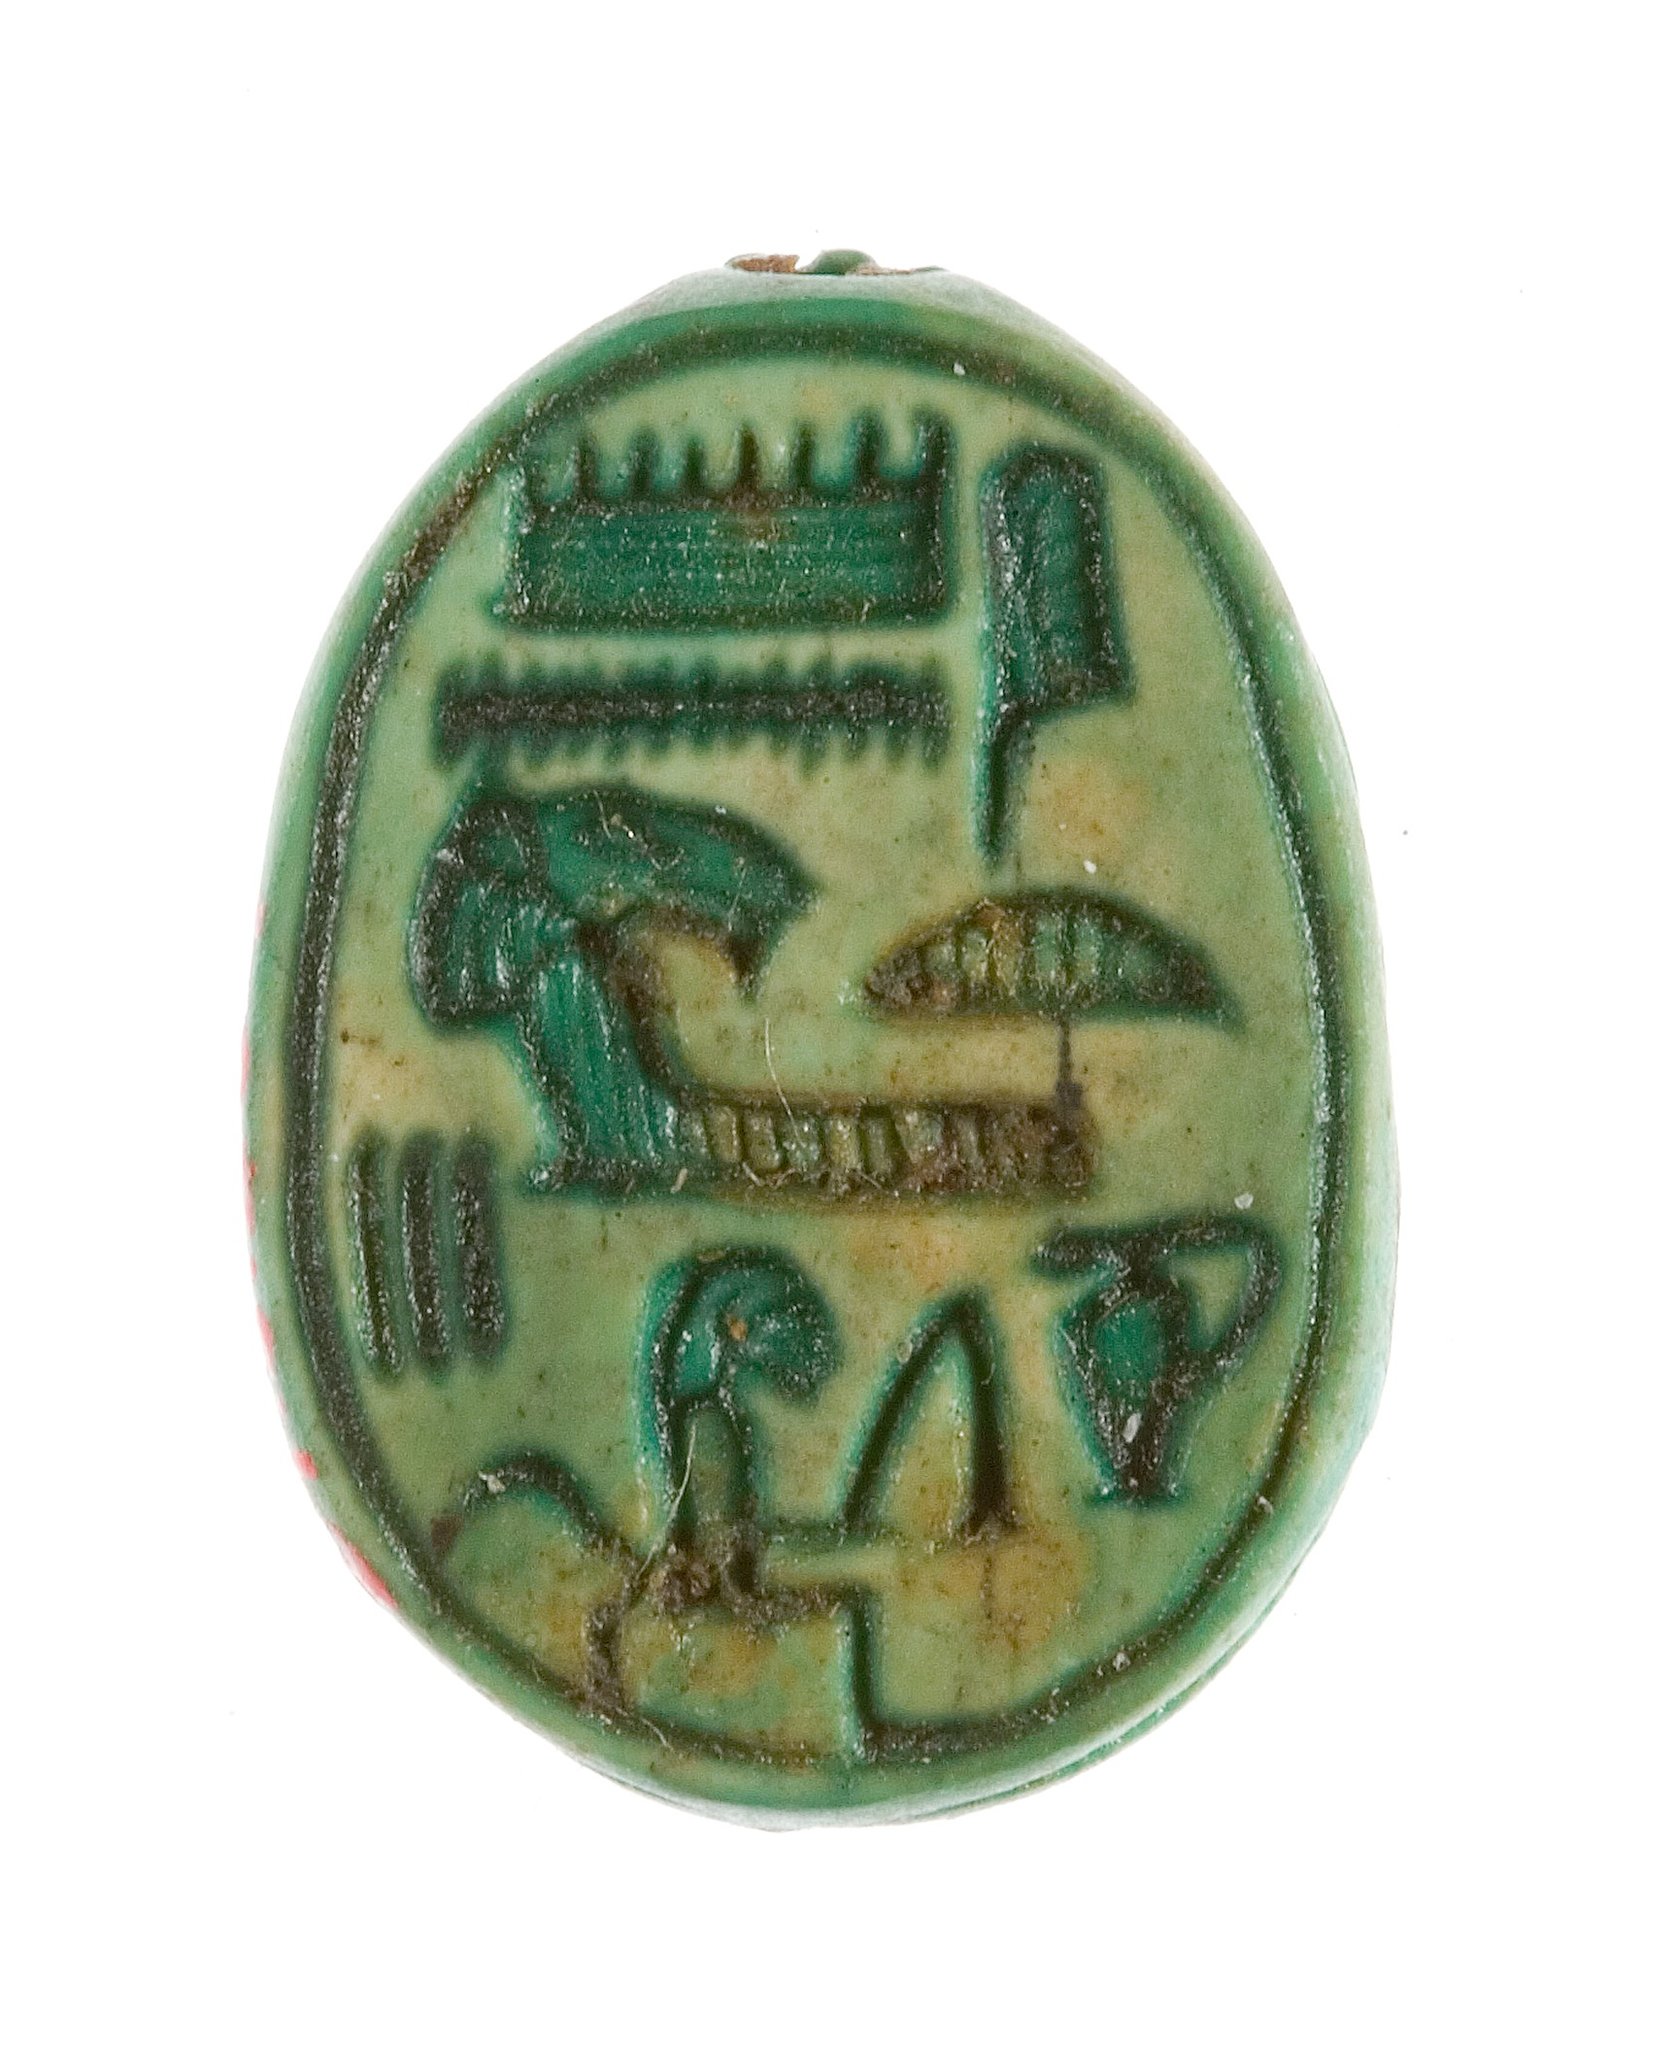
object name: scarab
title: Scarab Inscribed Hatshepsut United with Amun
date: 1479-1458 BCE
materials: stone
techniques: glazing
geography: egypt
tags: hieroglyphs,amun,scarabs